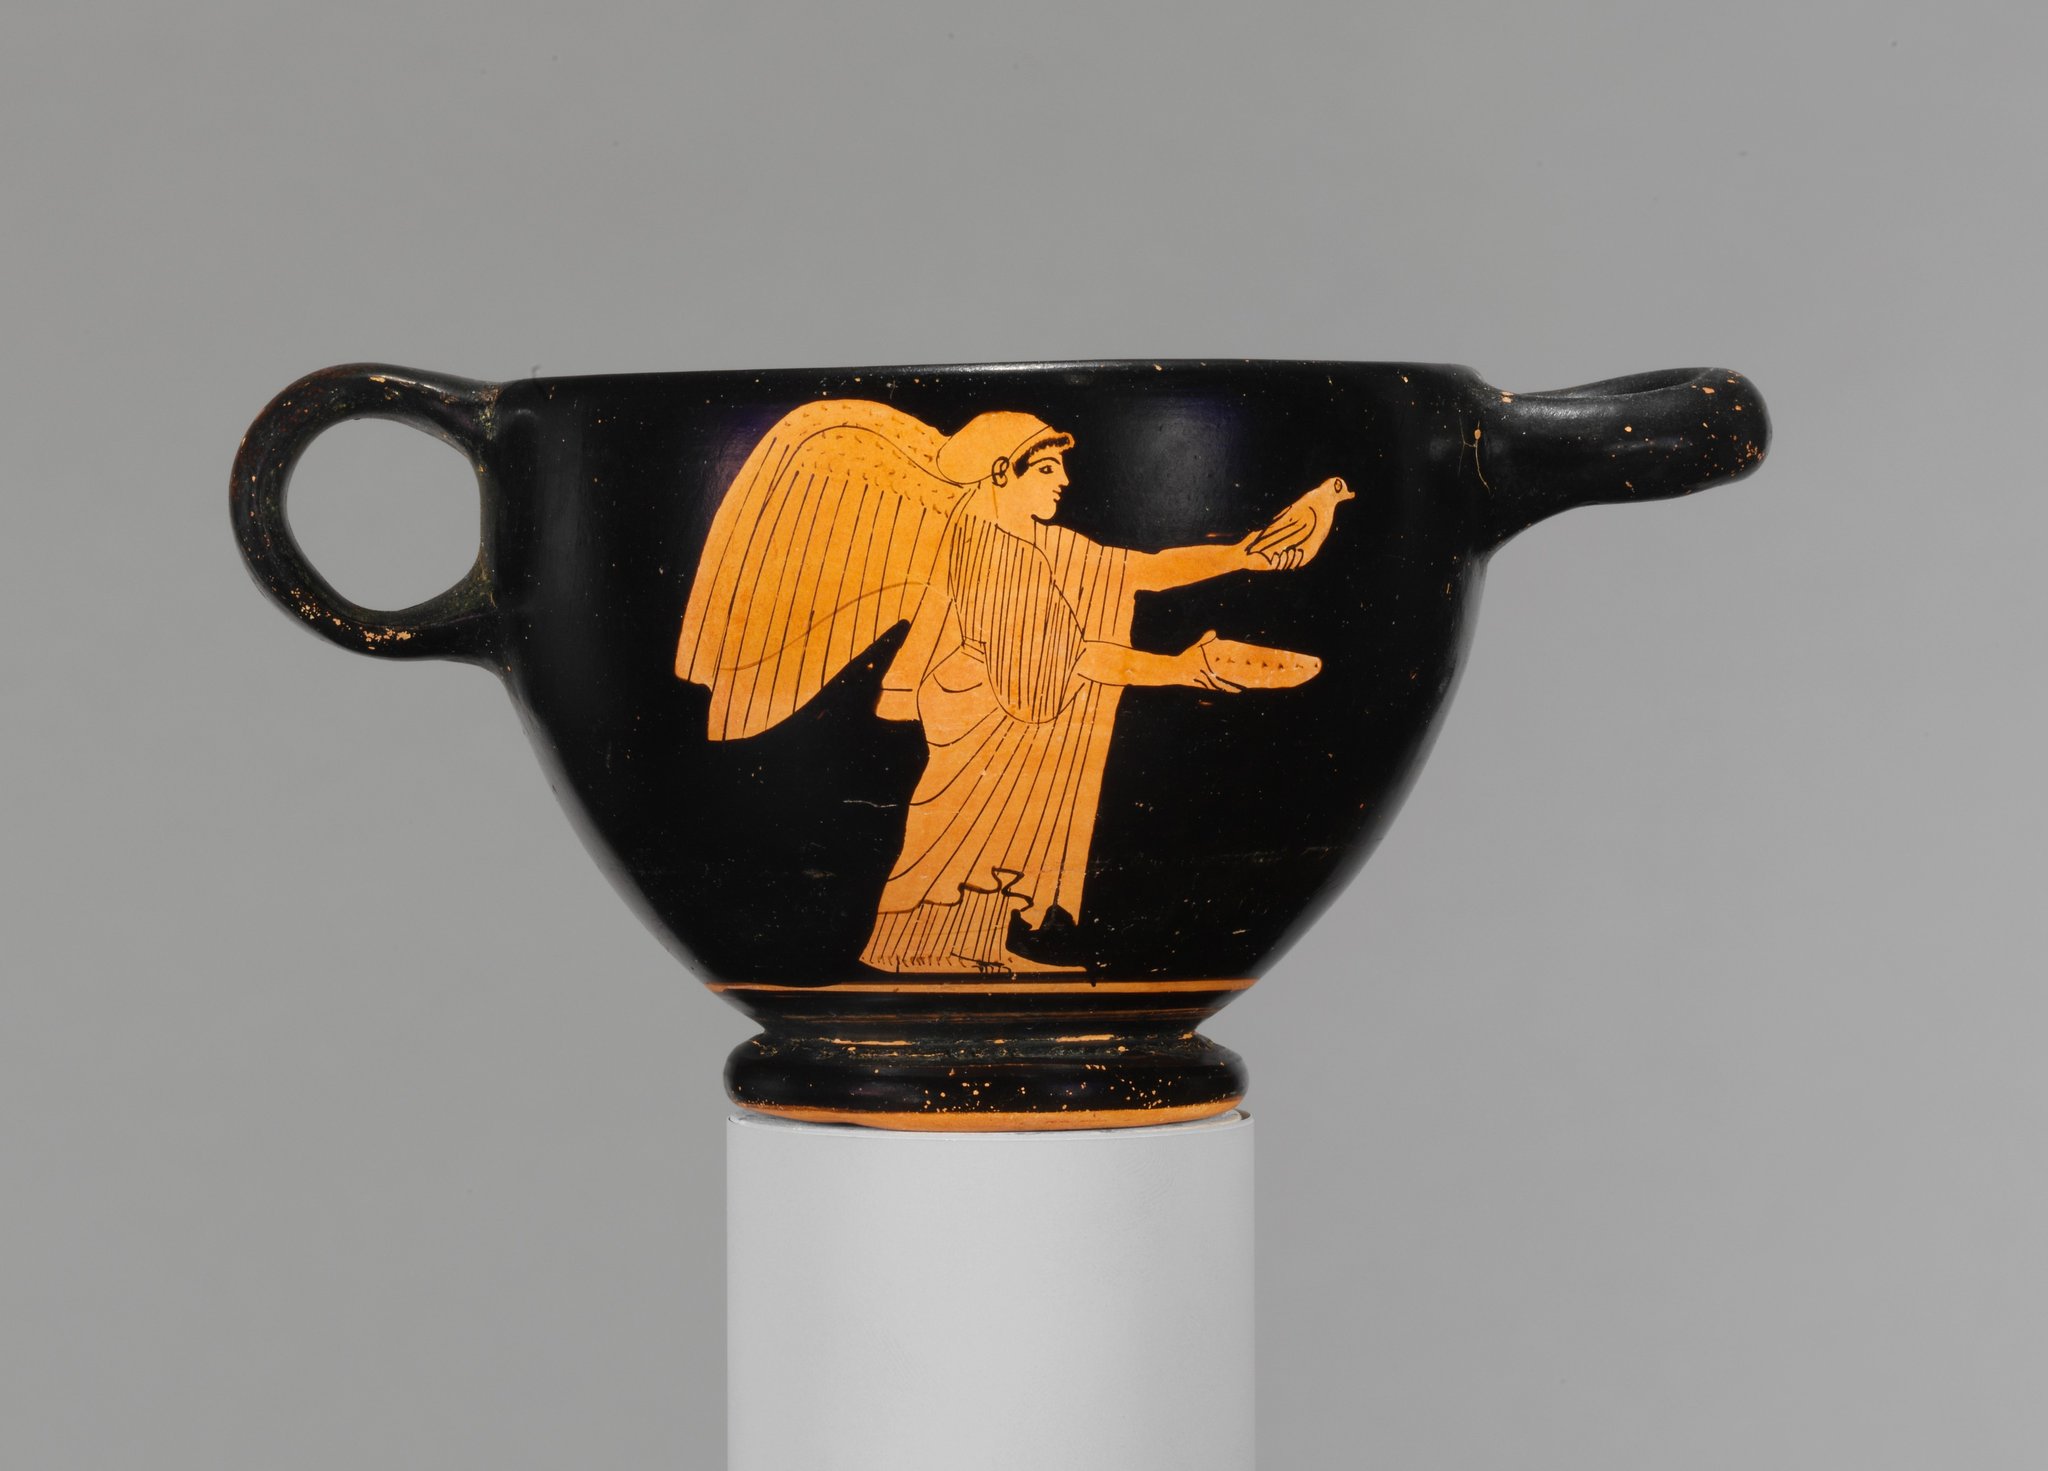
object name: skyphos, glaux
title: Terracotta skyphos (deep drinking cup)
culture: greek, attic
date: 460 BCE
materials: terracotta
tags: birds,shields,athena,nike